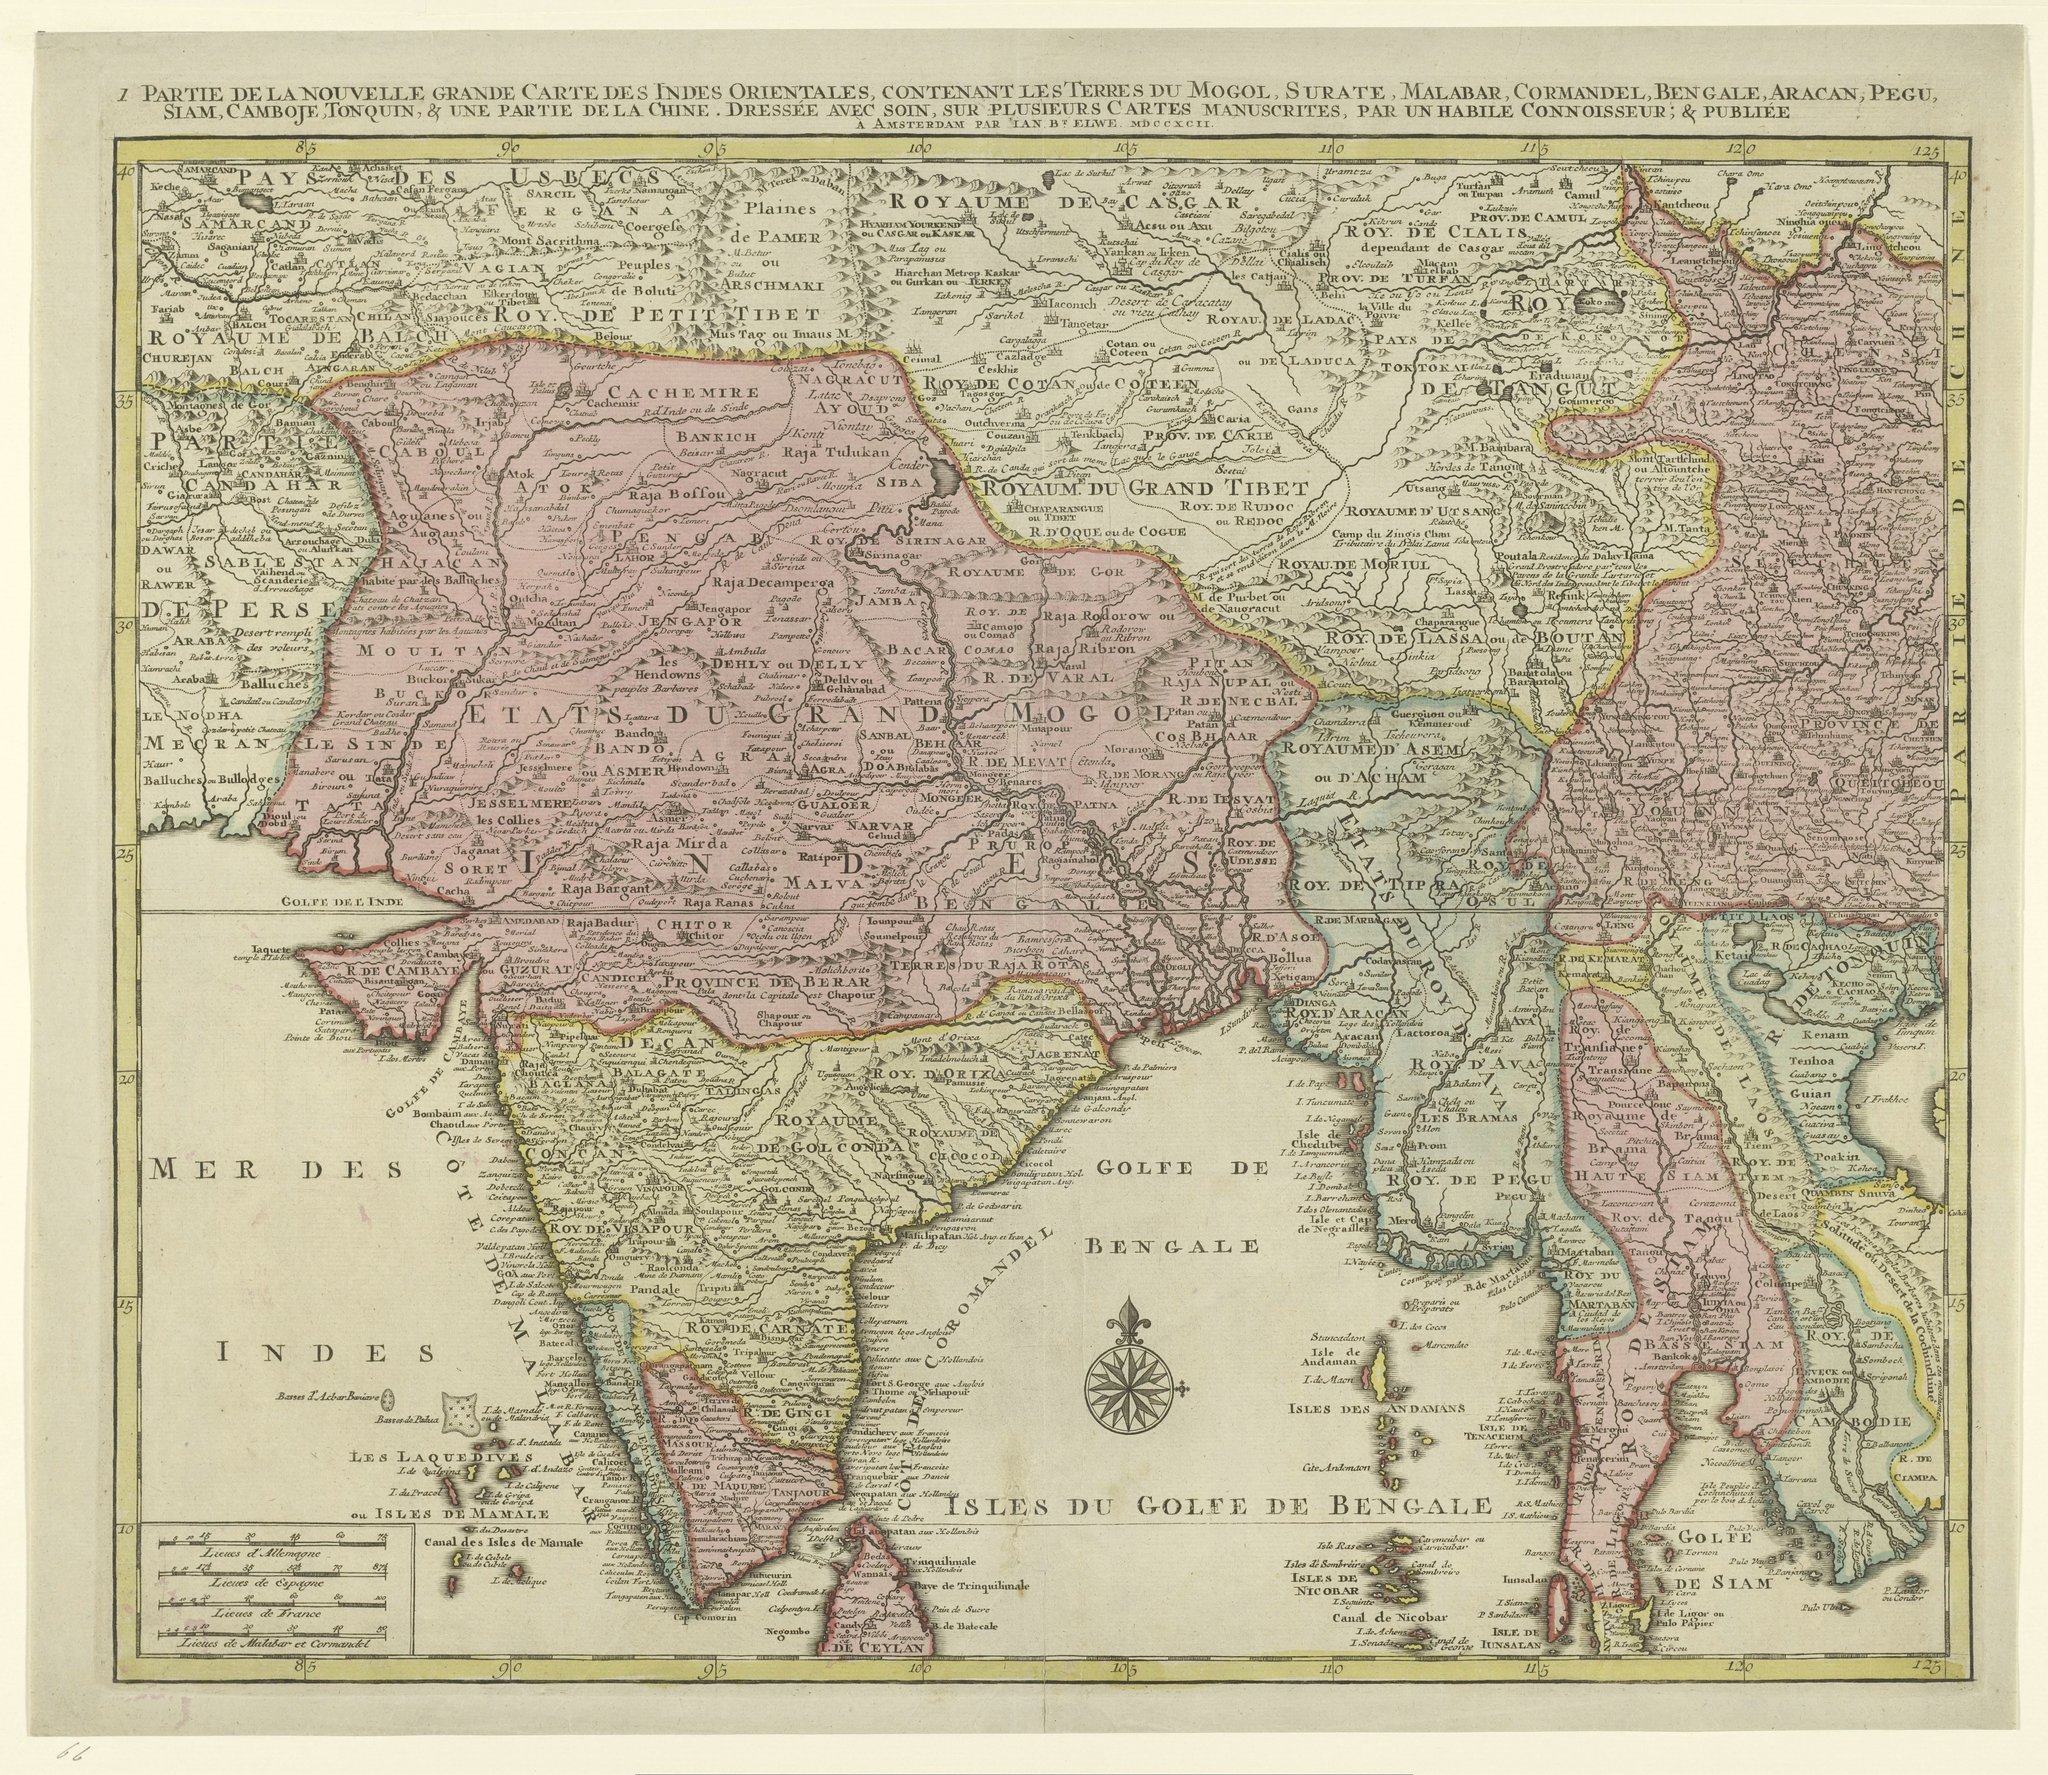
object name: map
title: 1 Partie de la nouvelle grande carte des Indes Orientales : contenant les terres du Mogol, Surate, Malabar, Cormandel, Bengale, Aracan, Pegu, Siam, Camboje, Tonquin & une partie de la Chine / dressée avec soin, sur plusieurs cartes manuscrites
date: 1792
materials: paper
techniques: engraving, hand coloring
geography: amsterdam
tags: maps of separate countries or regions, sri lanka, thailand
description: Kaart van Zuid-Azië, verschillende landsdelen verschillend gekleurd, middenonder windroos, linksonder schaal in Duitse, Spaanse en Franse mijlen en mijlen van Malabar en Cormandel (1:8 mijl).